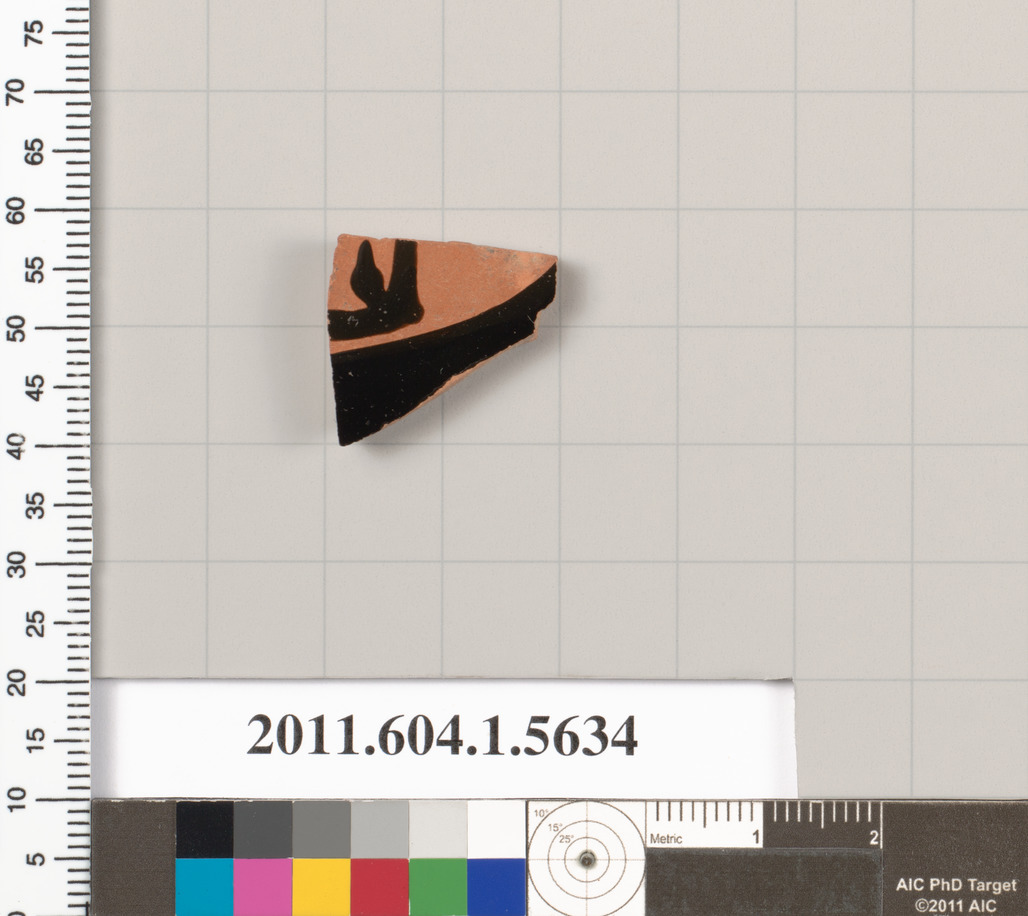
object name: kylix fragment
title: Terracotta fragment of a kylix (drinking cup)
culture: greek, attic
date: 510-490 BCE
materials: terracotta